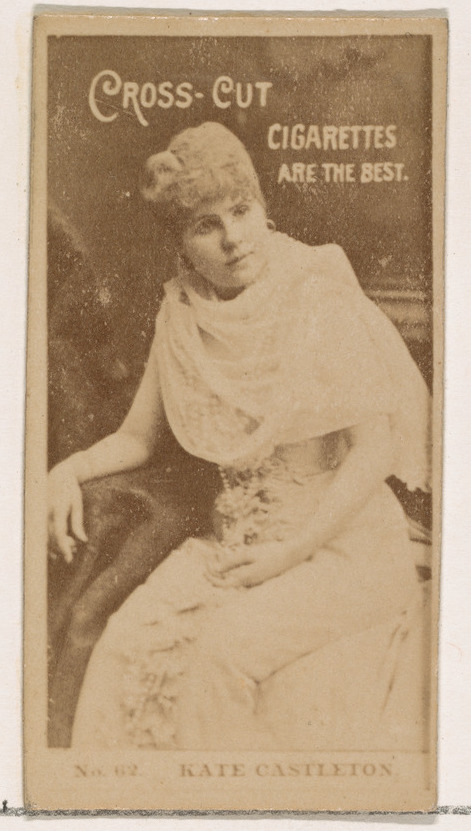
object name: print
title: Card Number 62, Kate Castleton, from the Actors and Actresses series (N145-2) issued by Duke Sons & Co. to promote Cross Cut Cigarettes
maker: w. duke, sons & co.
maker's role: publisher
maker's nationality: american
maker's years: 1870-1920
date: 1880-1889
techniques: albumen silver print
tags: portraits,women,actresses